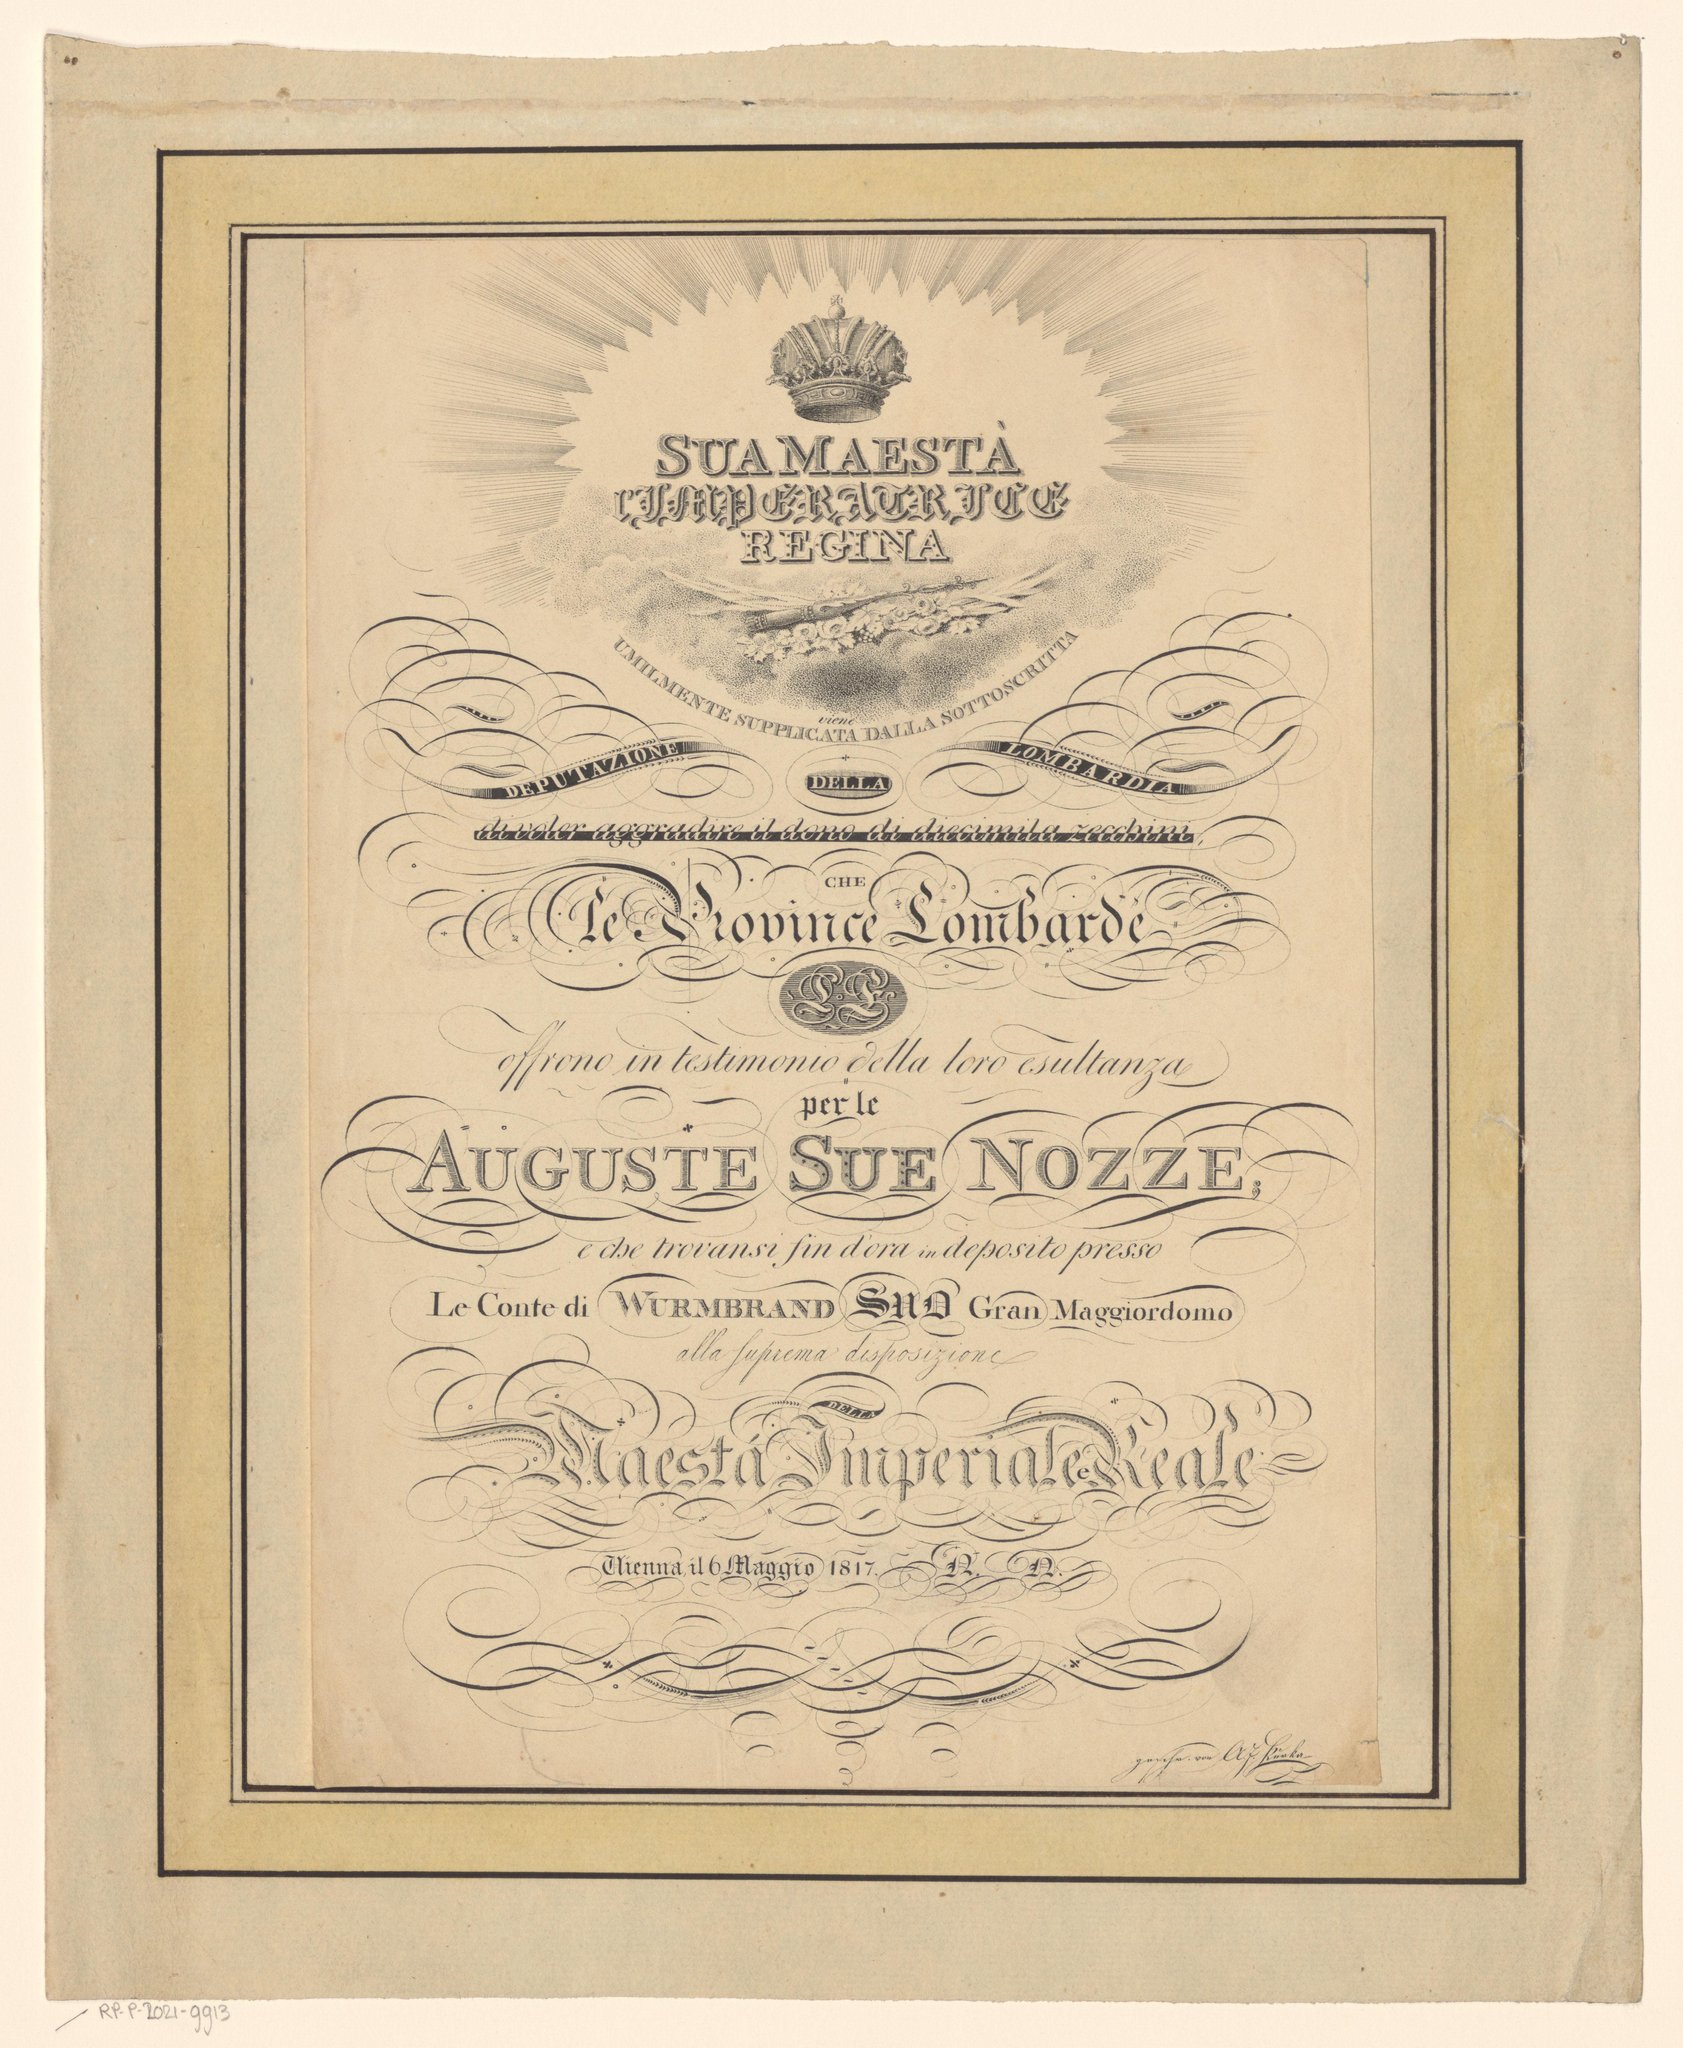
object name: print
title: Aankondiging van het geschenk van 10.000 dukaten van Lombardije aan Caroline Augusta van Beieren, keizerin van Oostenrijk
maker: Anonymous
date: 1817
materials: paper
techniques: lithograph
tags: vienna, caroline augusta van beieren (keizerin van oostenrijk), historical persons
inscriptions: date